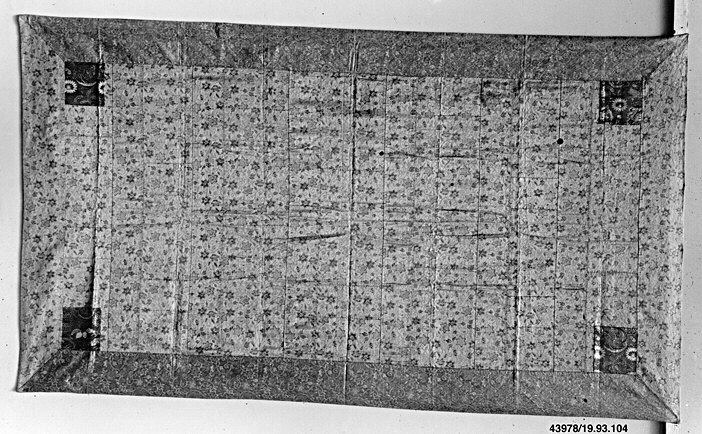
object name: robe, priest's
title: Priest's Robe (Shichijō)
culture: japanese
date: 1656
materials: silk